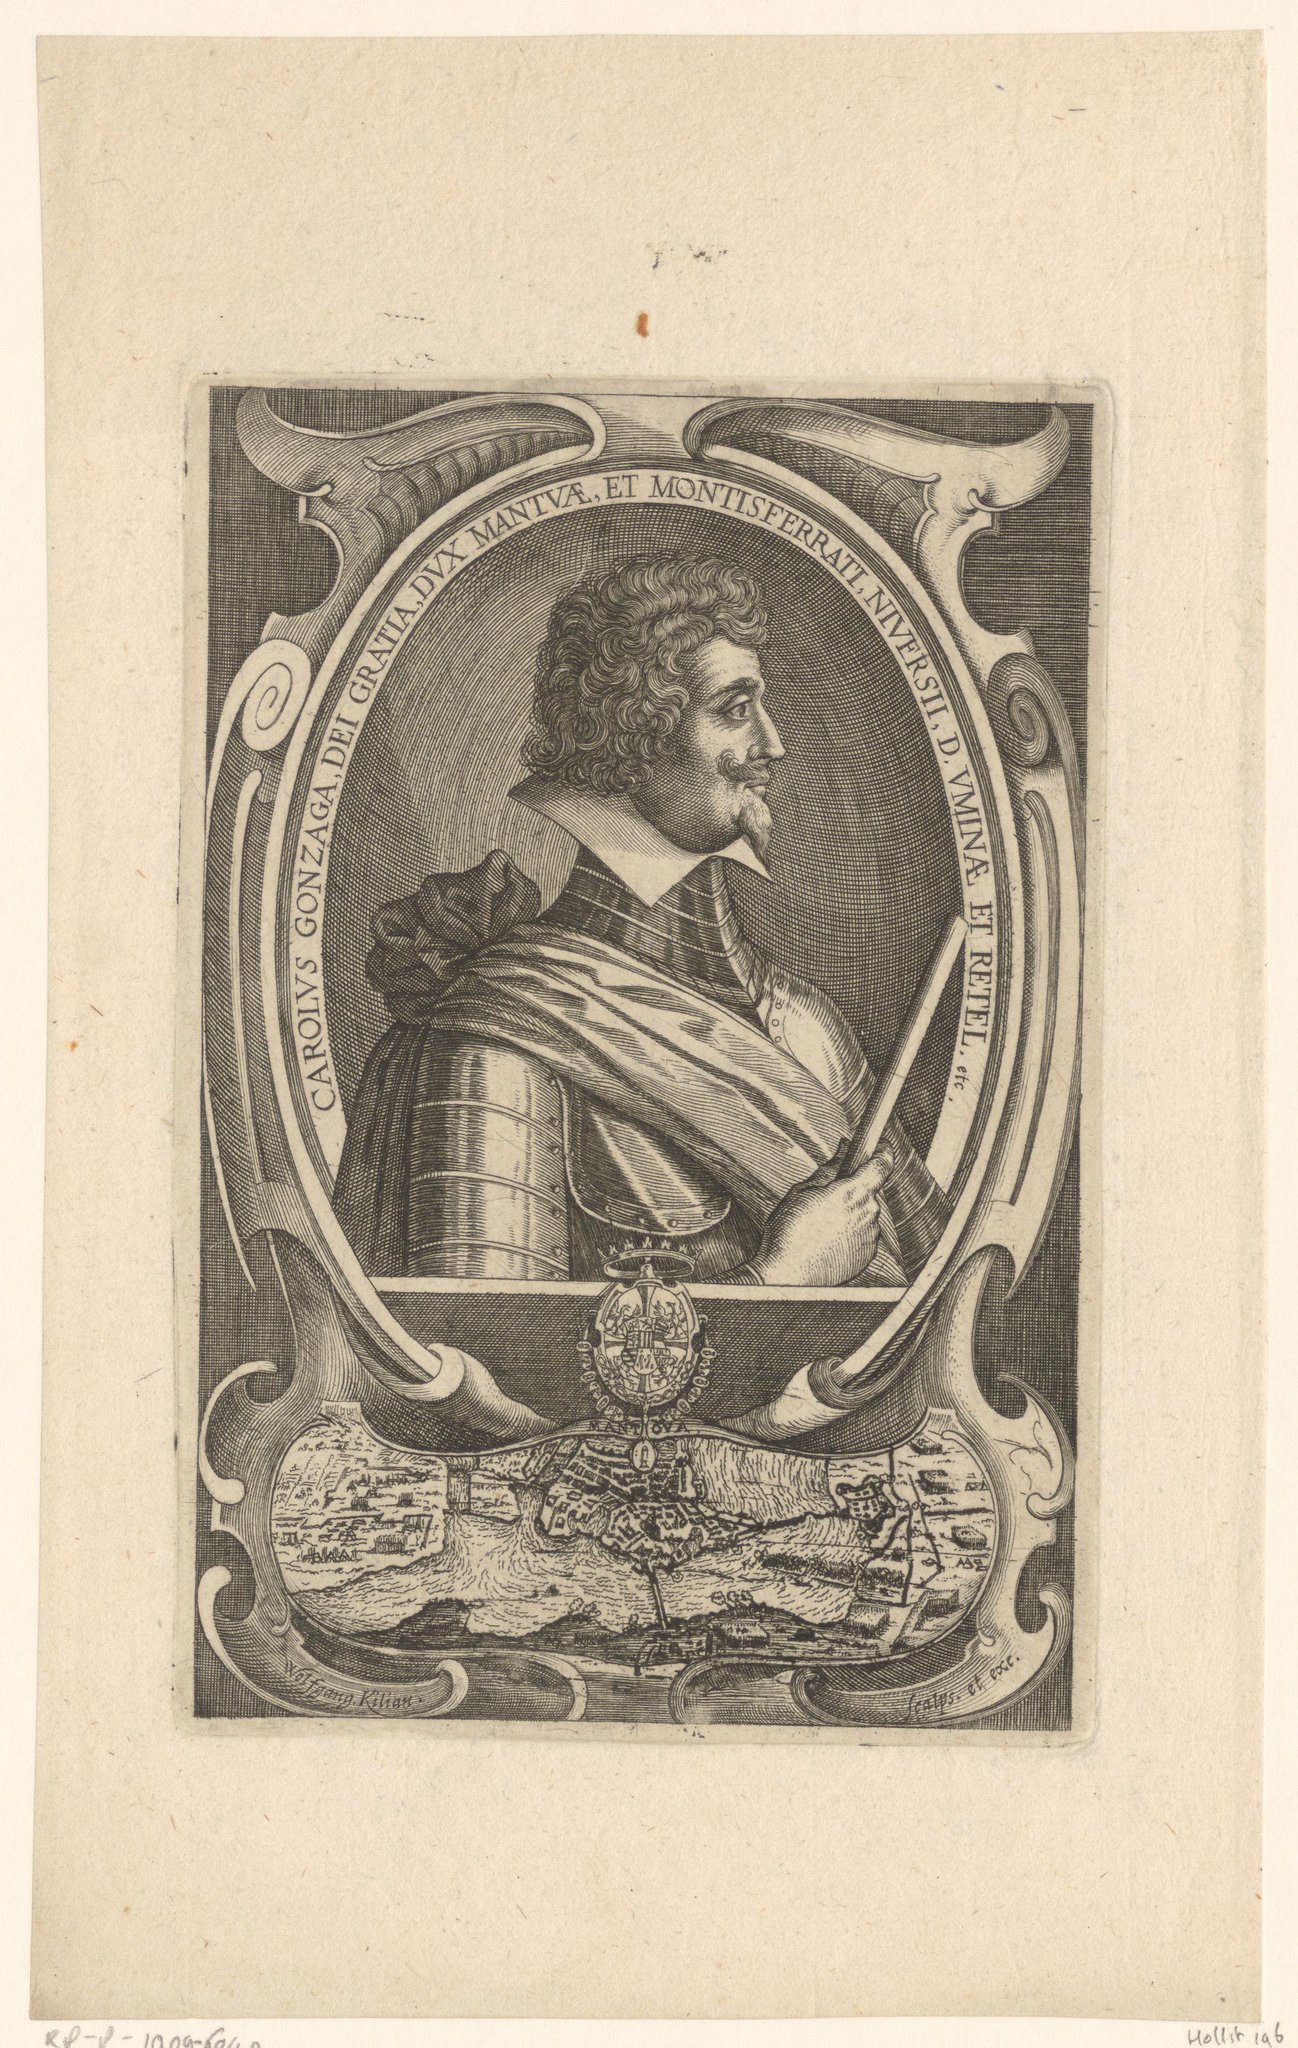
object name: print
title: Portret van Carlo Gonzaga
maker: wolfgang kilian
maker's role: print maker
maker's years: 1581-1662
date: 1619-1662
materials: paper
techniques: engraving, etching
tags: historical persons, regent, substitute ruler; viceroy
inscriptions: collector's mark: Lugt 2228